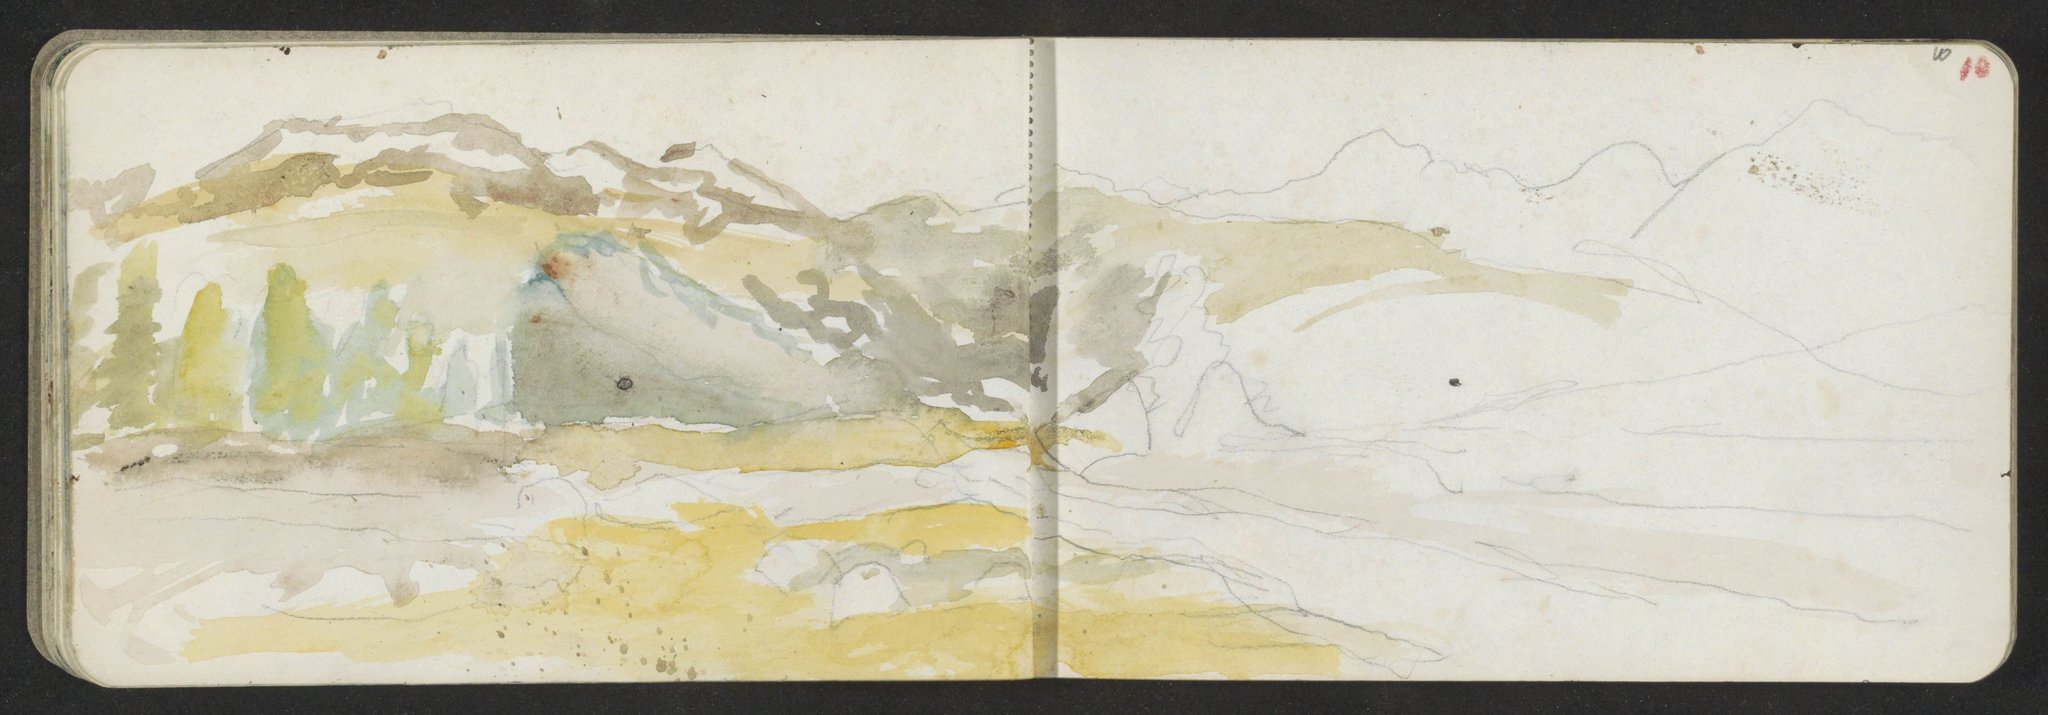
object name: sketchbook leaf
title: Berglandschap in Pontresina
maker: jozef israëls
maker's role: draughtsman, painter, print maker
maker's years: 1824-1911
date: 1869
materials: paper, pencil, watercolor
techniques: brush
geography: pontresina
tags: mountain-range, snow peaks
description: Blad 9 verso en 10 recto uit een schetsboek met 36 bladen.